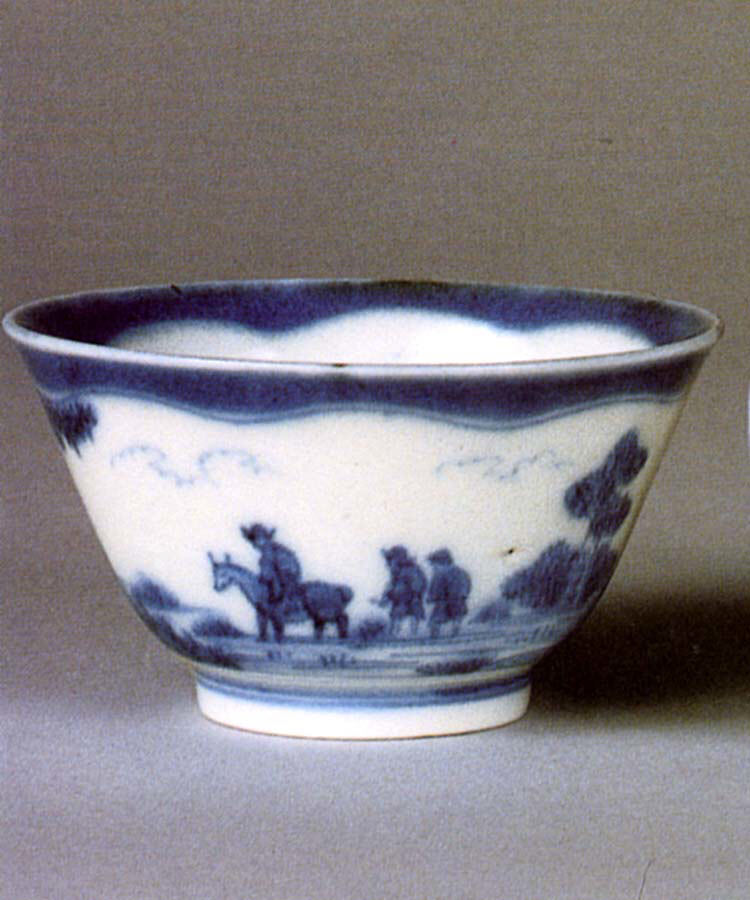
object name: one of a pair of cup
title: One of a Pair of Cups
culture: japanese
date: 1701-1733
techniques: underglaze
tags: human figures